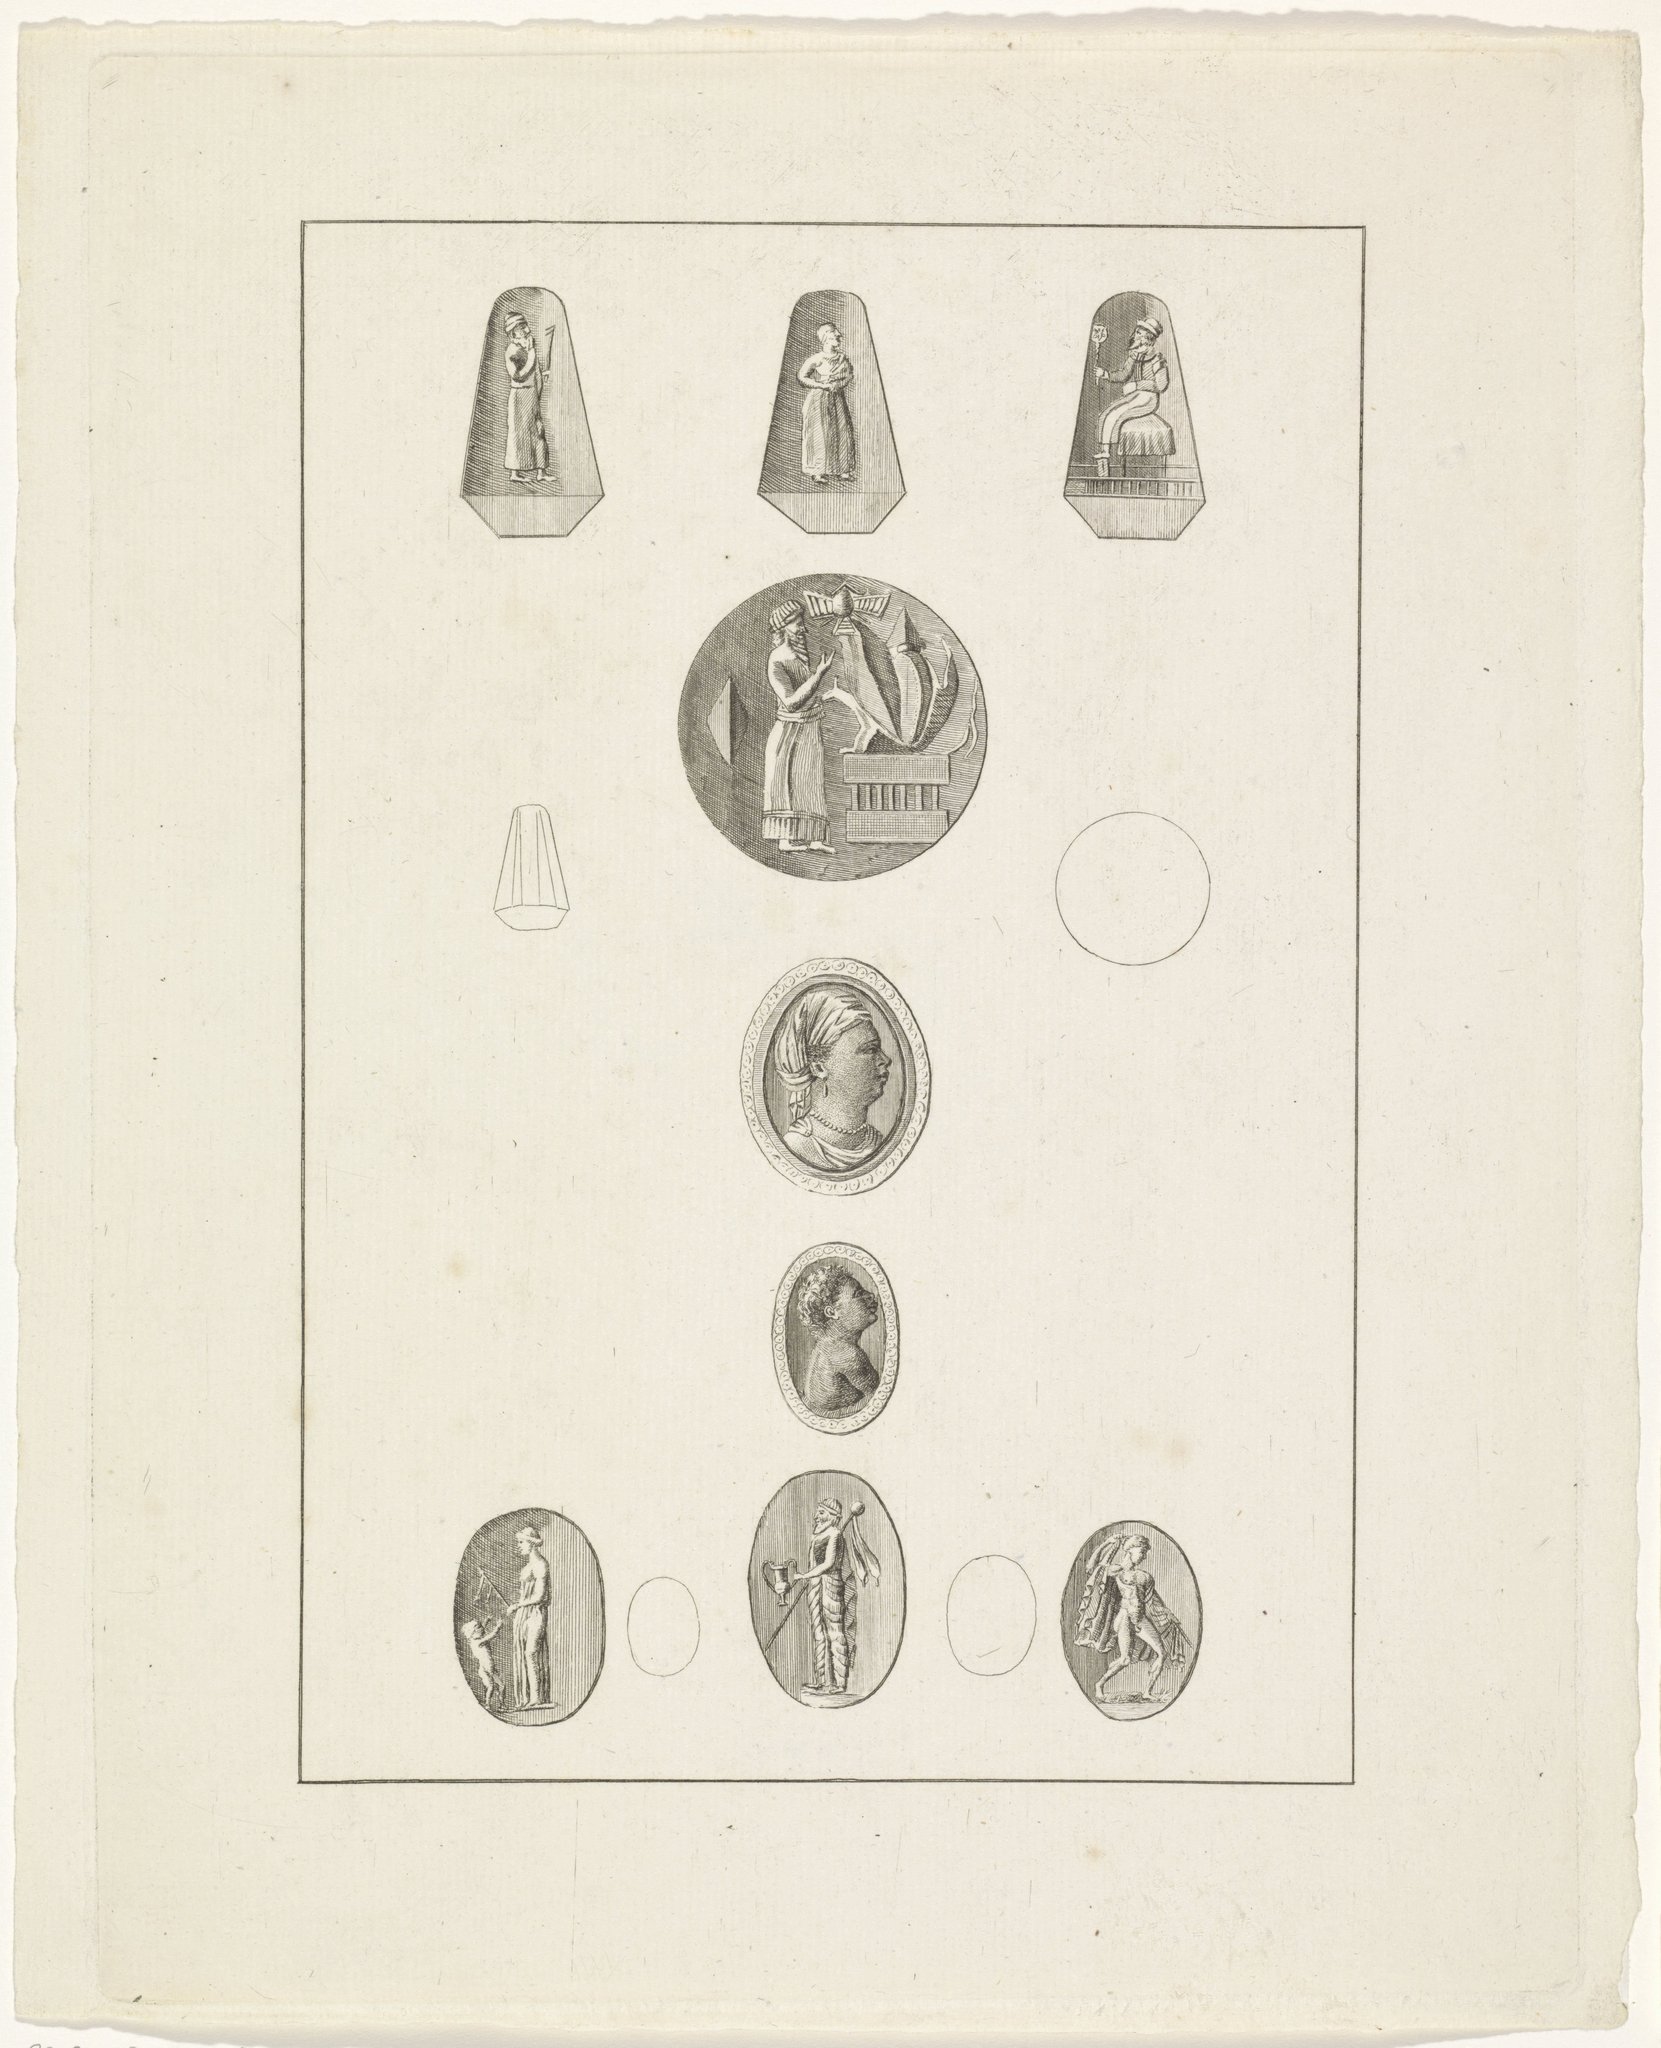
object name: print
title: Cameeën of zegels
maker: Anonymous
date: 1750-1900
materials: paper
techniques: etching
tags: seal, stamp, gem, gemstone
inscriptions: collector's mark: Lugt 2228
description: Verschillende cameeën of zegels met voorstellingen van mensen erop.